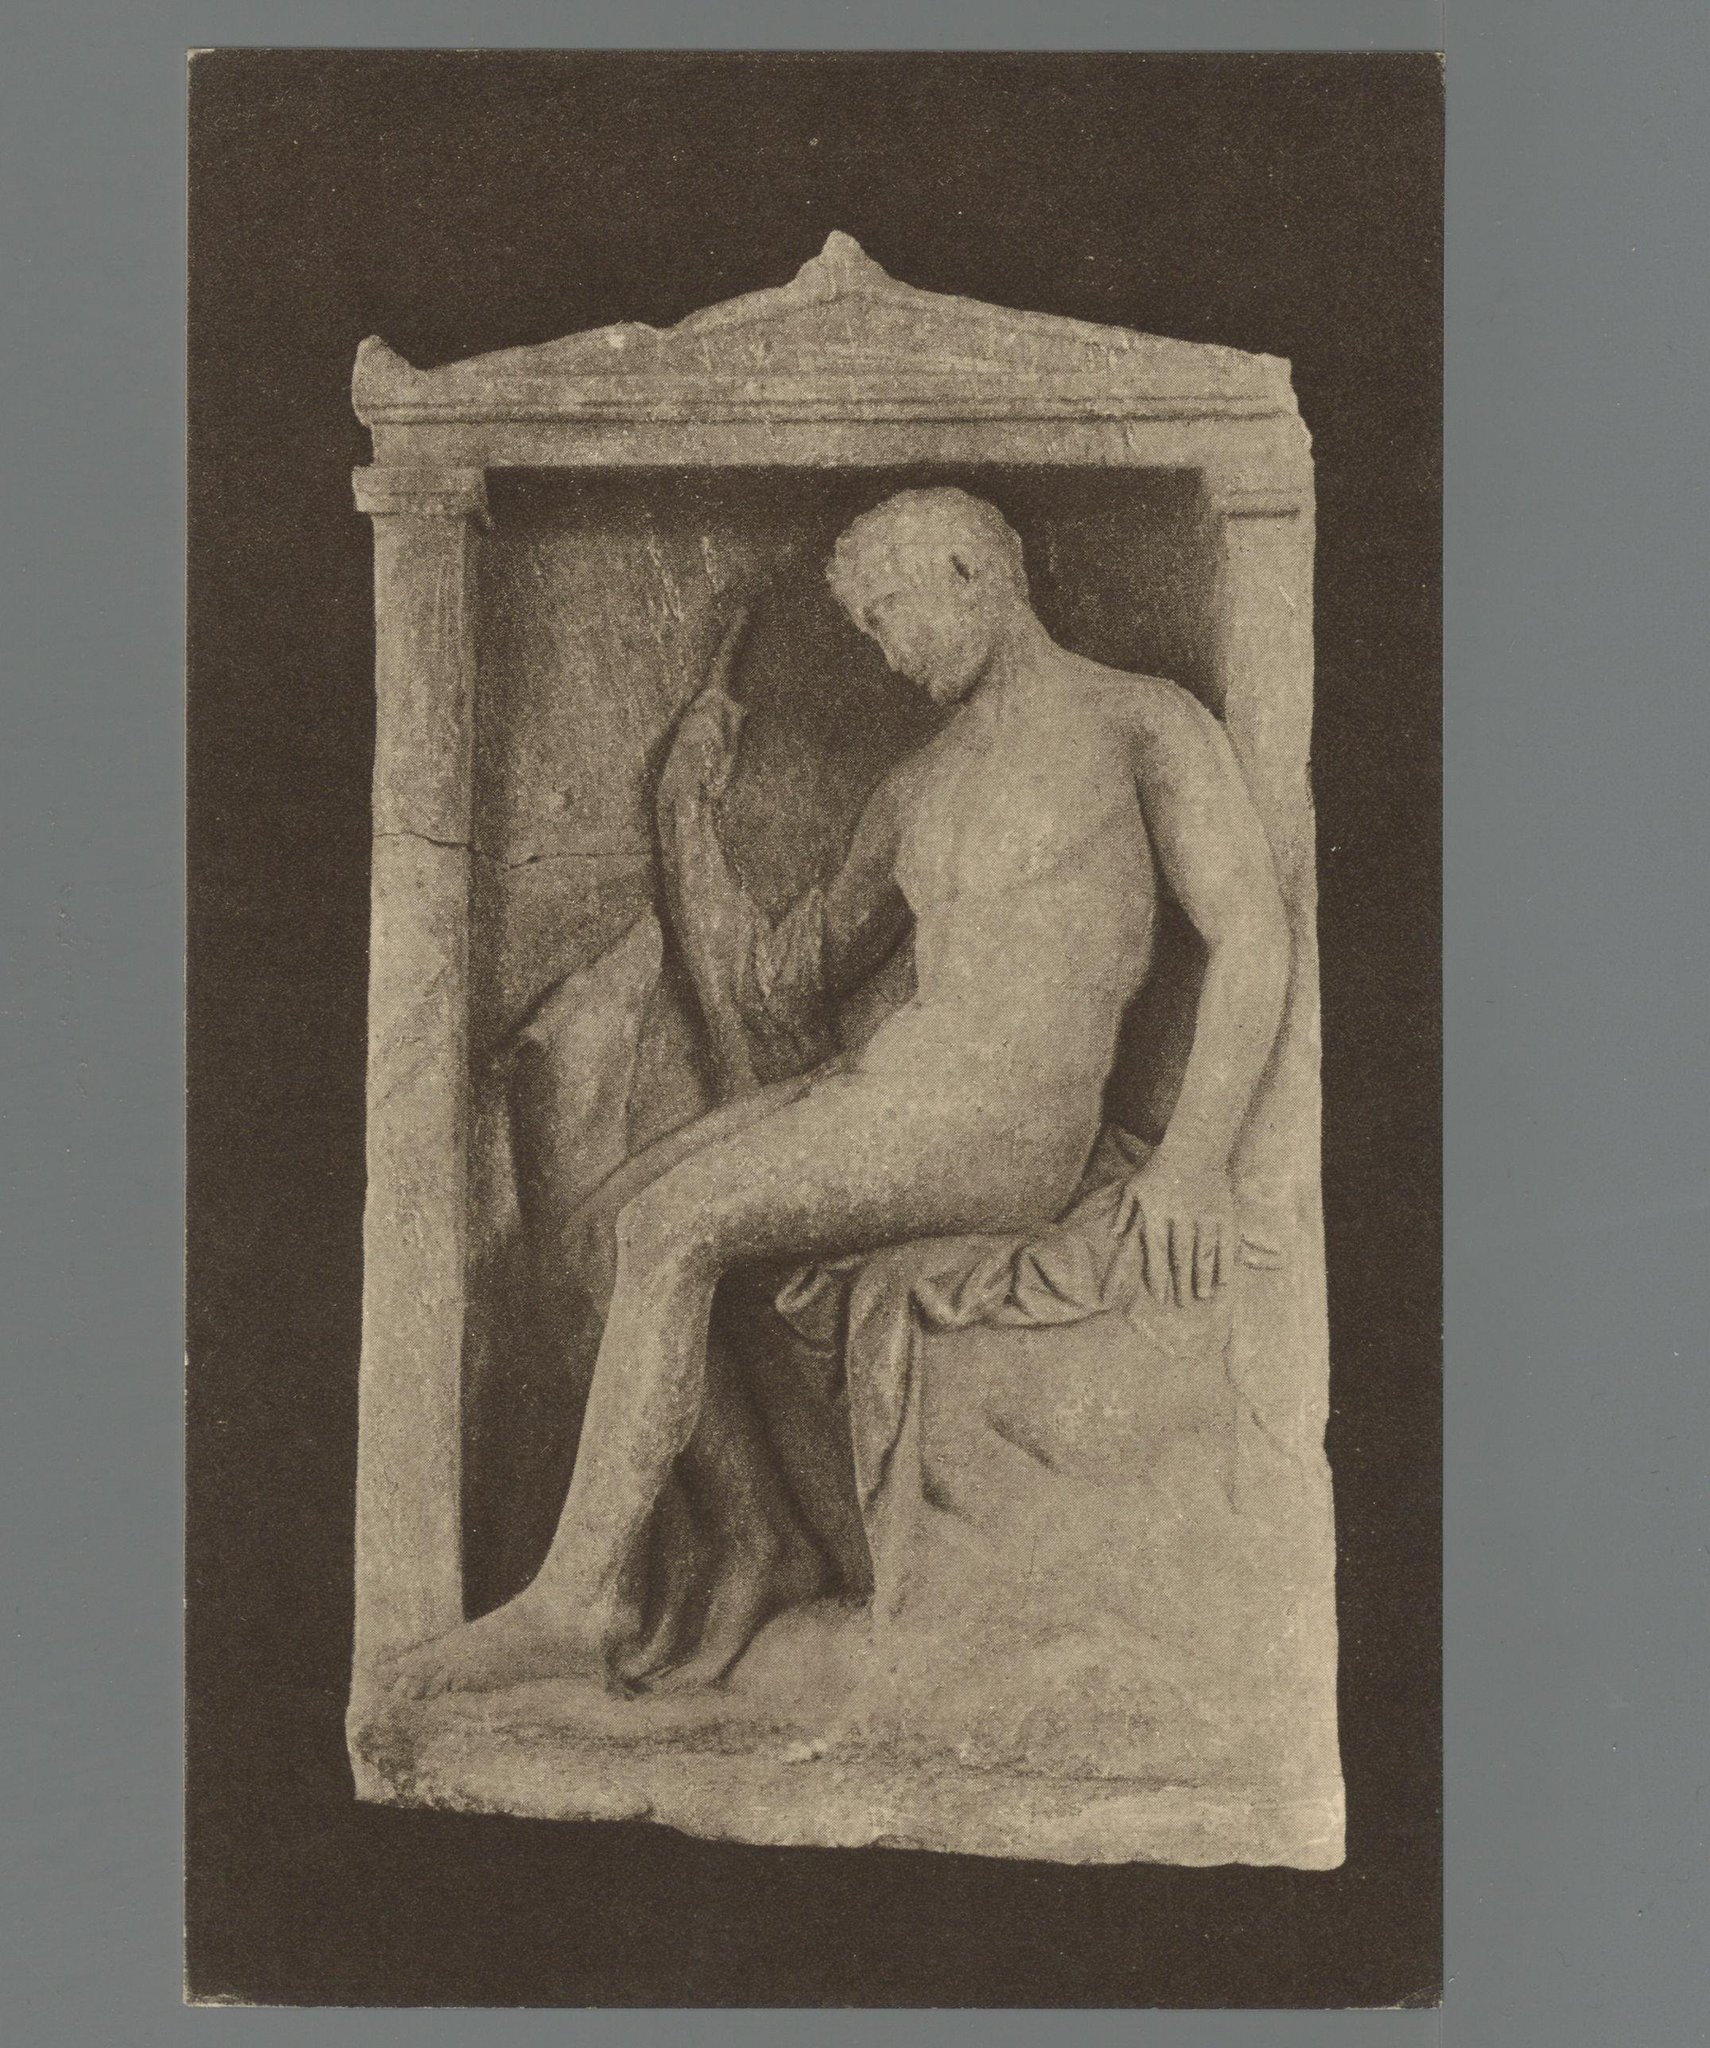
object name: photomechanical print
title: Attisches Grabrelief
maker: Anonymous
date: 1905-1930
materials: cardboard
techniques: rotogravure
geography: munich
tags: permanent exhibition, museum